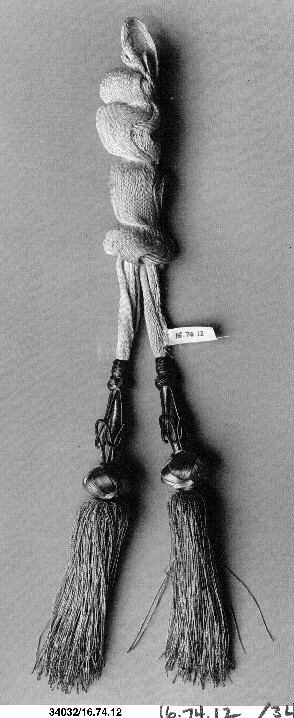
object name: tassel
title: Tassels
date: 1867-1900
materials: silk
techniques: gilding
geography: iran